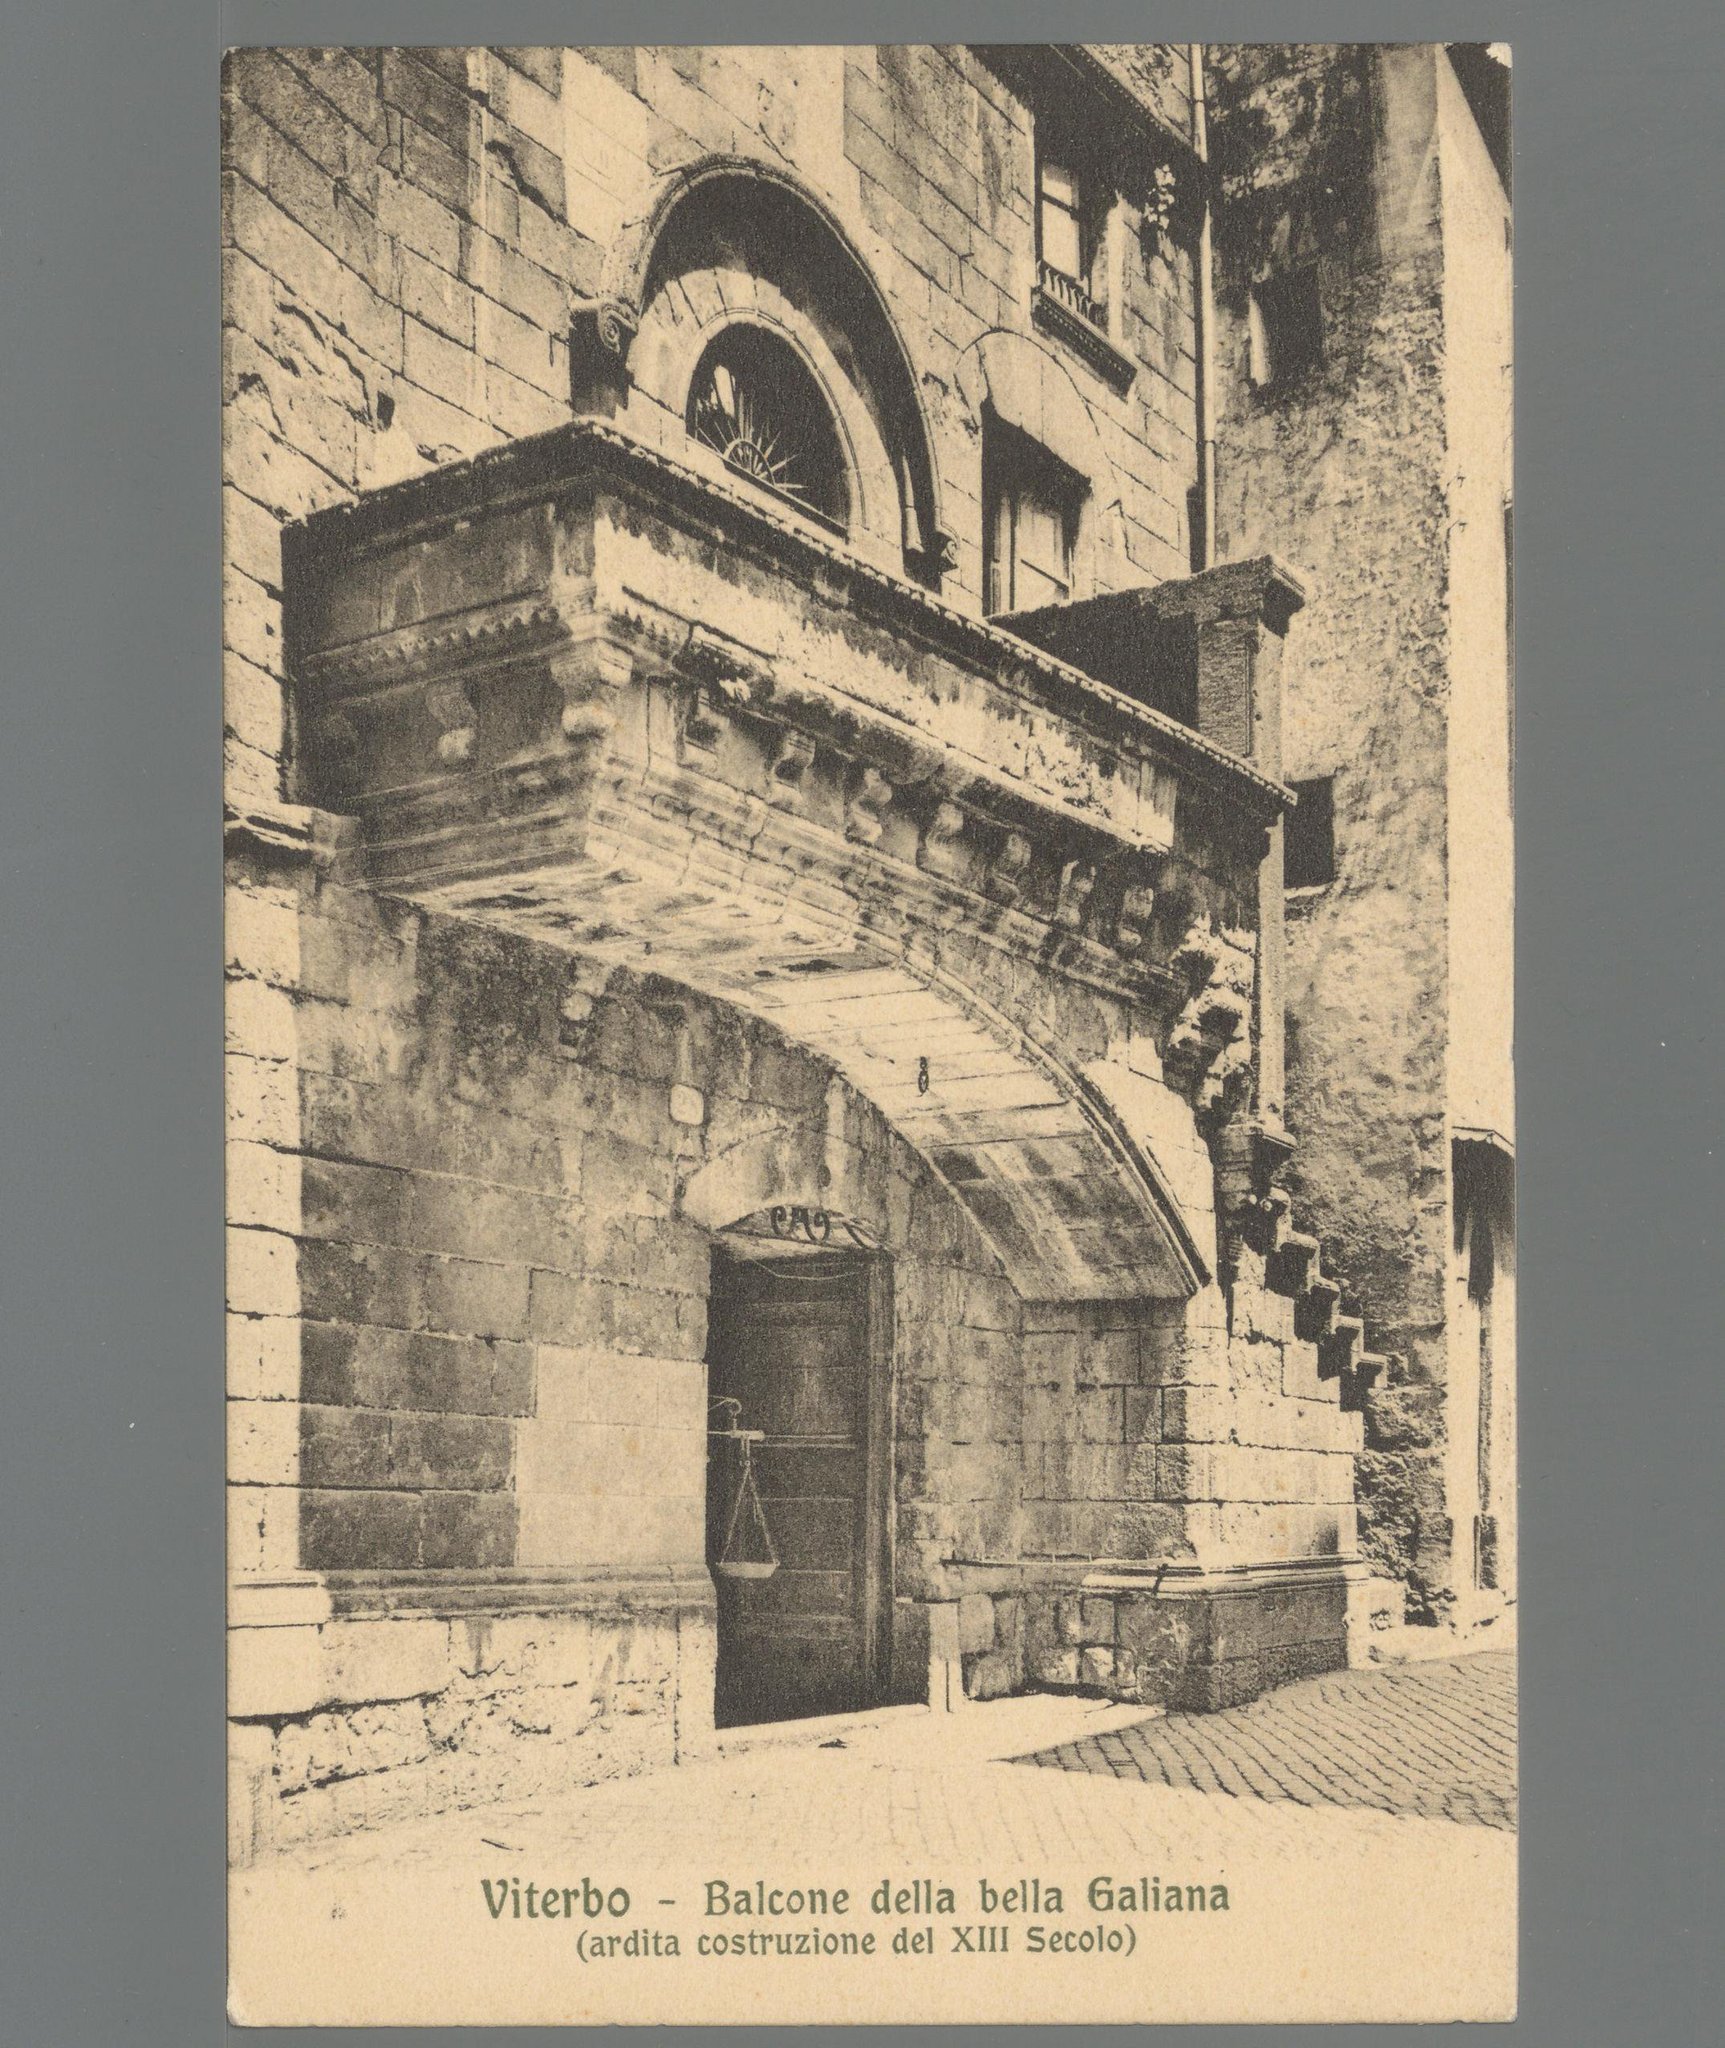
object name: ansichtkaart, prentbriefkaart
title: Viterbo. Balcone della bella Galiana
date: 1906-1930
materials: cardboard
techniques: photograph, writing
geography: viterbo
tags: urban housing, balcony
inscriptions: postage stamp